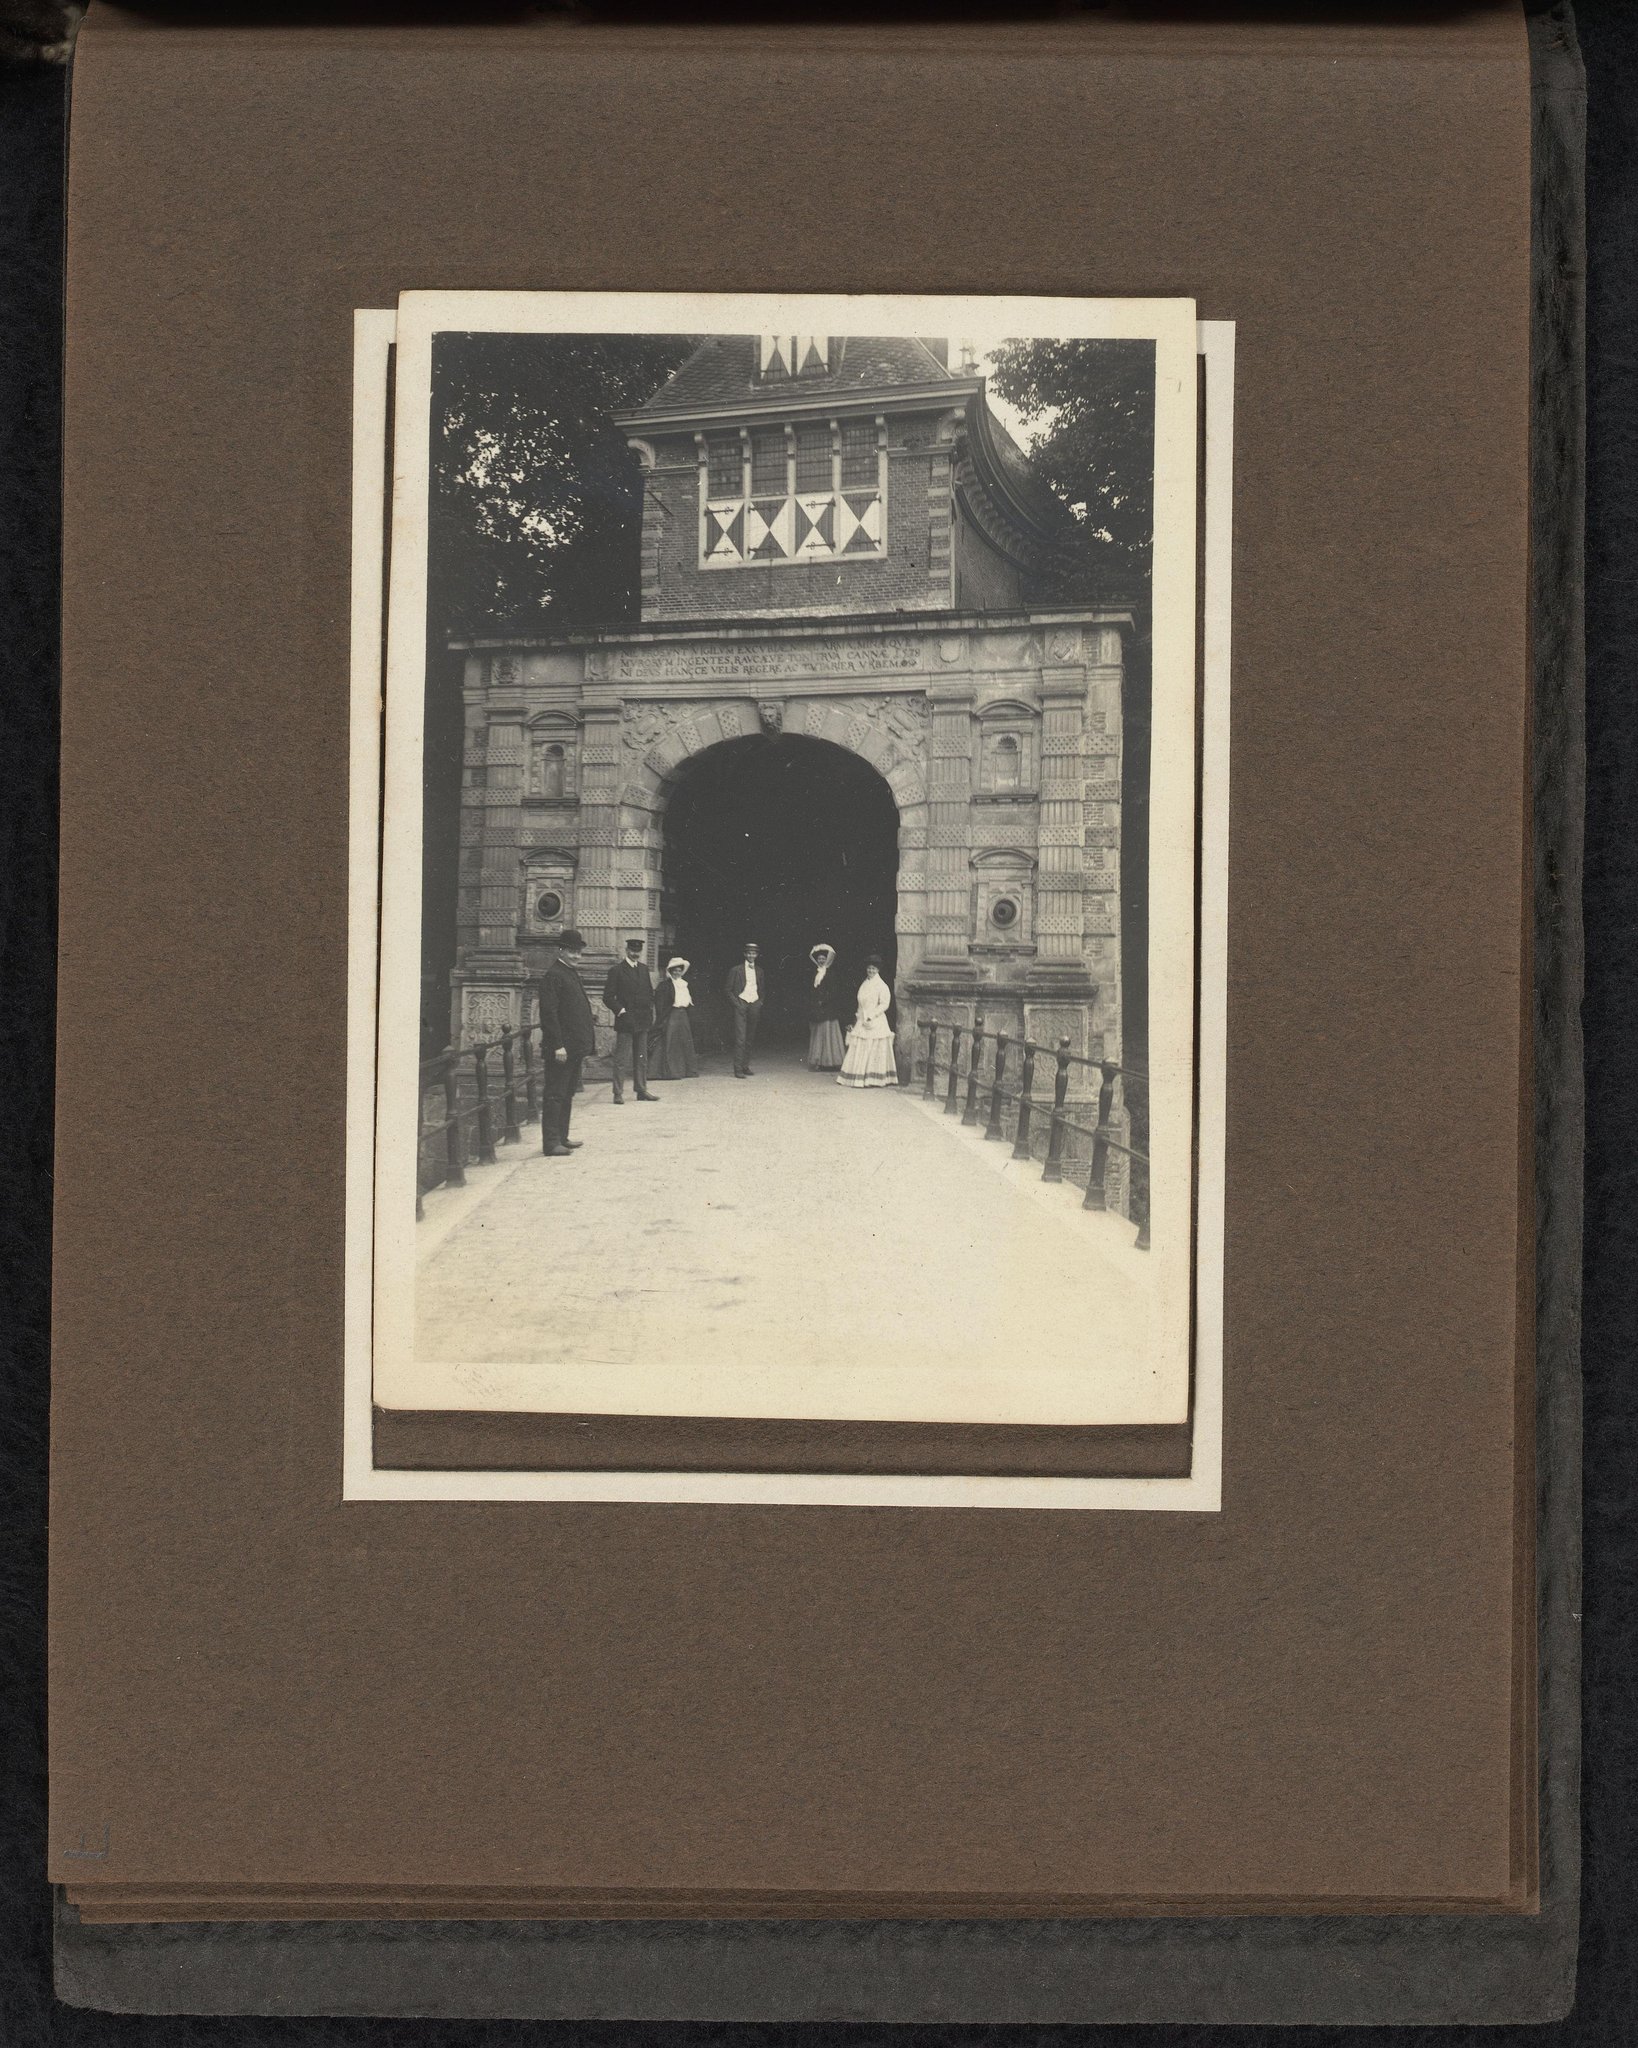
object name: album leaf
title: Gezelschap onder de Oosterpoort in Hoorn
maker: hendrik herman van den berg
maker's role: amateurfotograaf, jurist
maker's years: 1875-1944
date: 1908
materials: paper, cardboard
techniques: gelatin silver print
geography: hoorn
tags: historical persons, city-gate